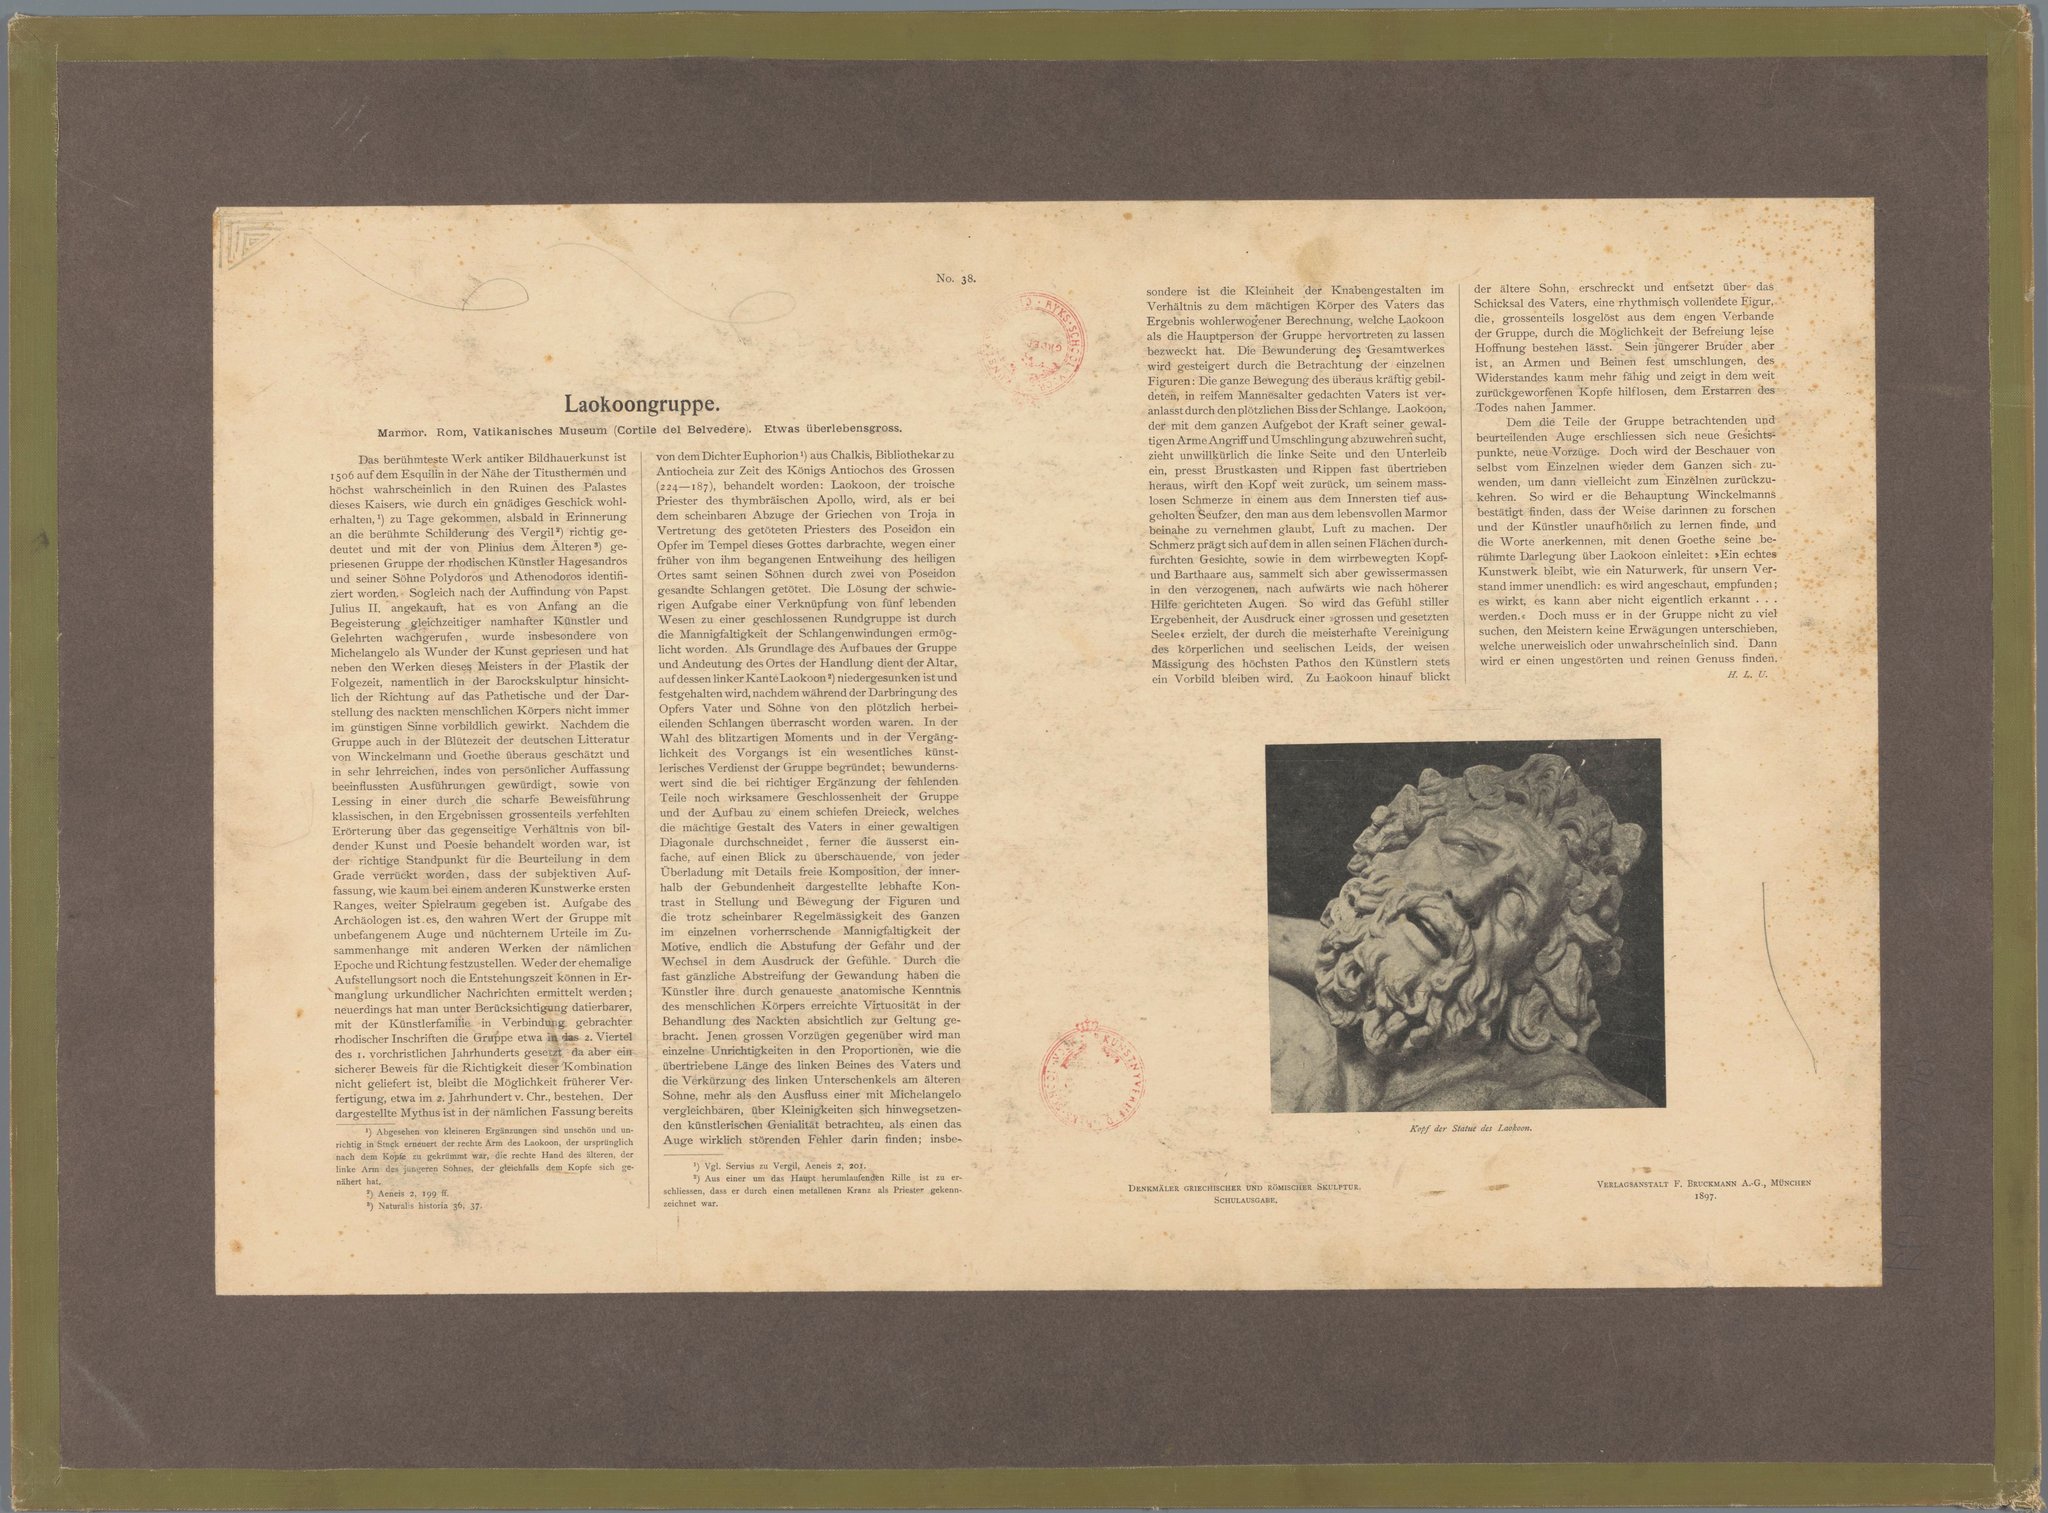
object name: photograph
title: Laokoongruppe.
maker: Anonymous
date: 1897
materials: cardboard, paper, ink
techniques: photograph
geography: munich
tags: laocoon and his twin sons are strangled by two serpents during the preparations for a sacrifice, sculpture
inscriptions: collector's mark: Lugt 3937, number: ‘No. 38.’, inscription: